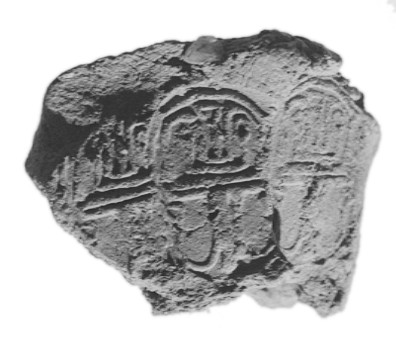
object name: sealing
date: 2030-1640 BCE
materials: clay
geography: egypt